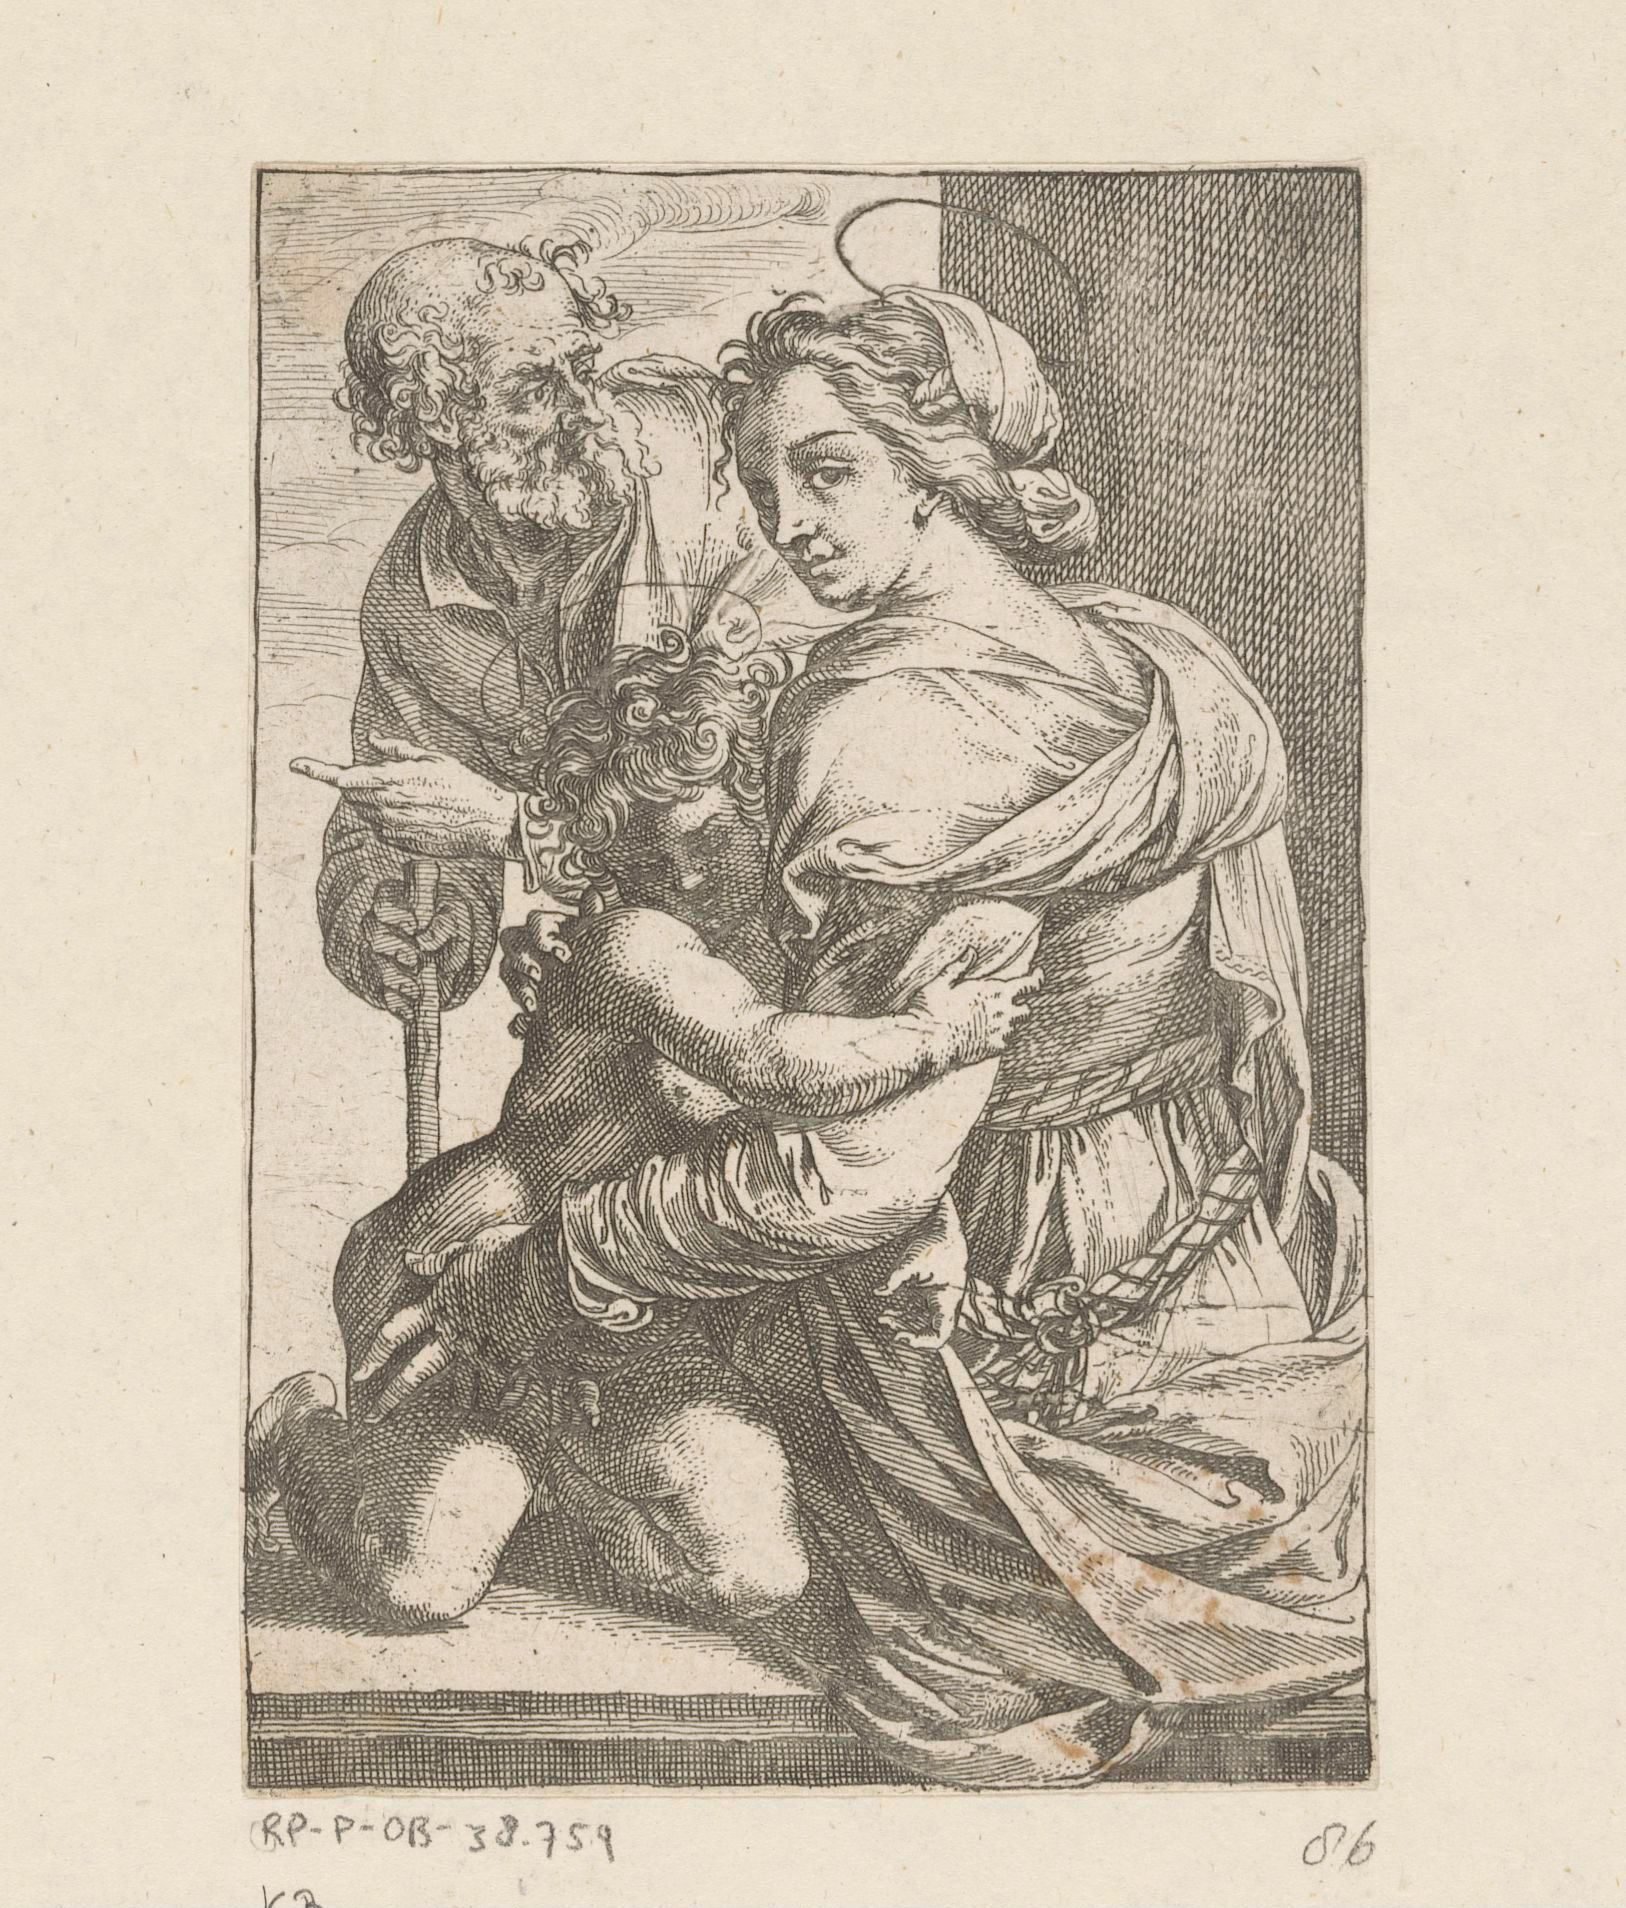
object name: print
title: Heilige Familie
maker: Anonymous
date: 1550-1599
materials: paper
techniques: etching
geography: italy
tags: holy family, and derived representations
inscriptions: collector's mark: Lugt 240